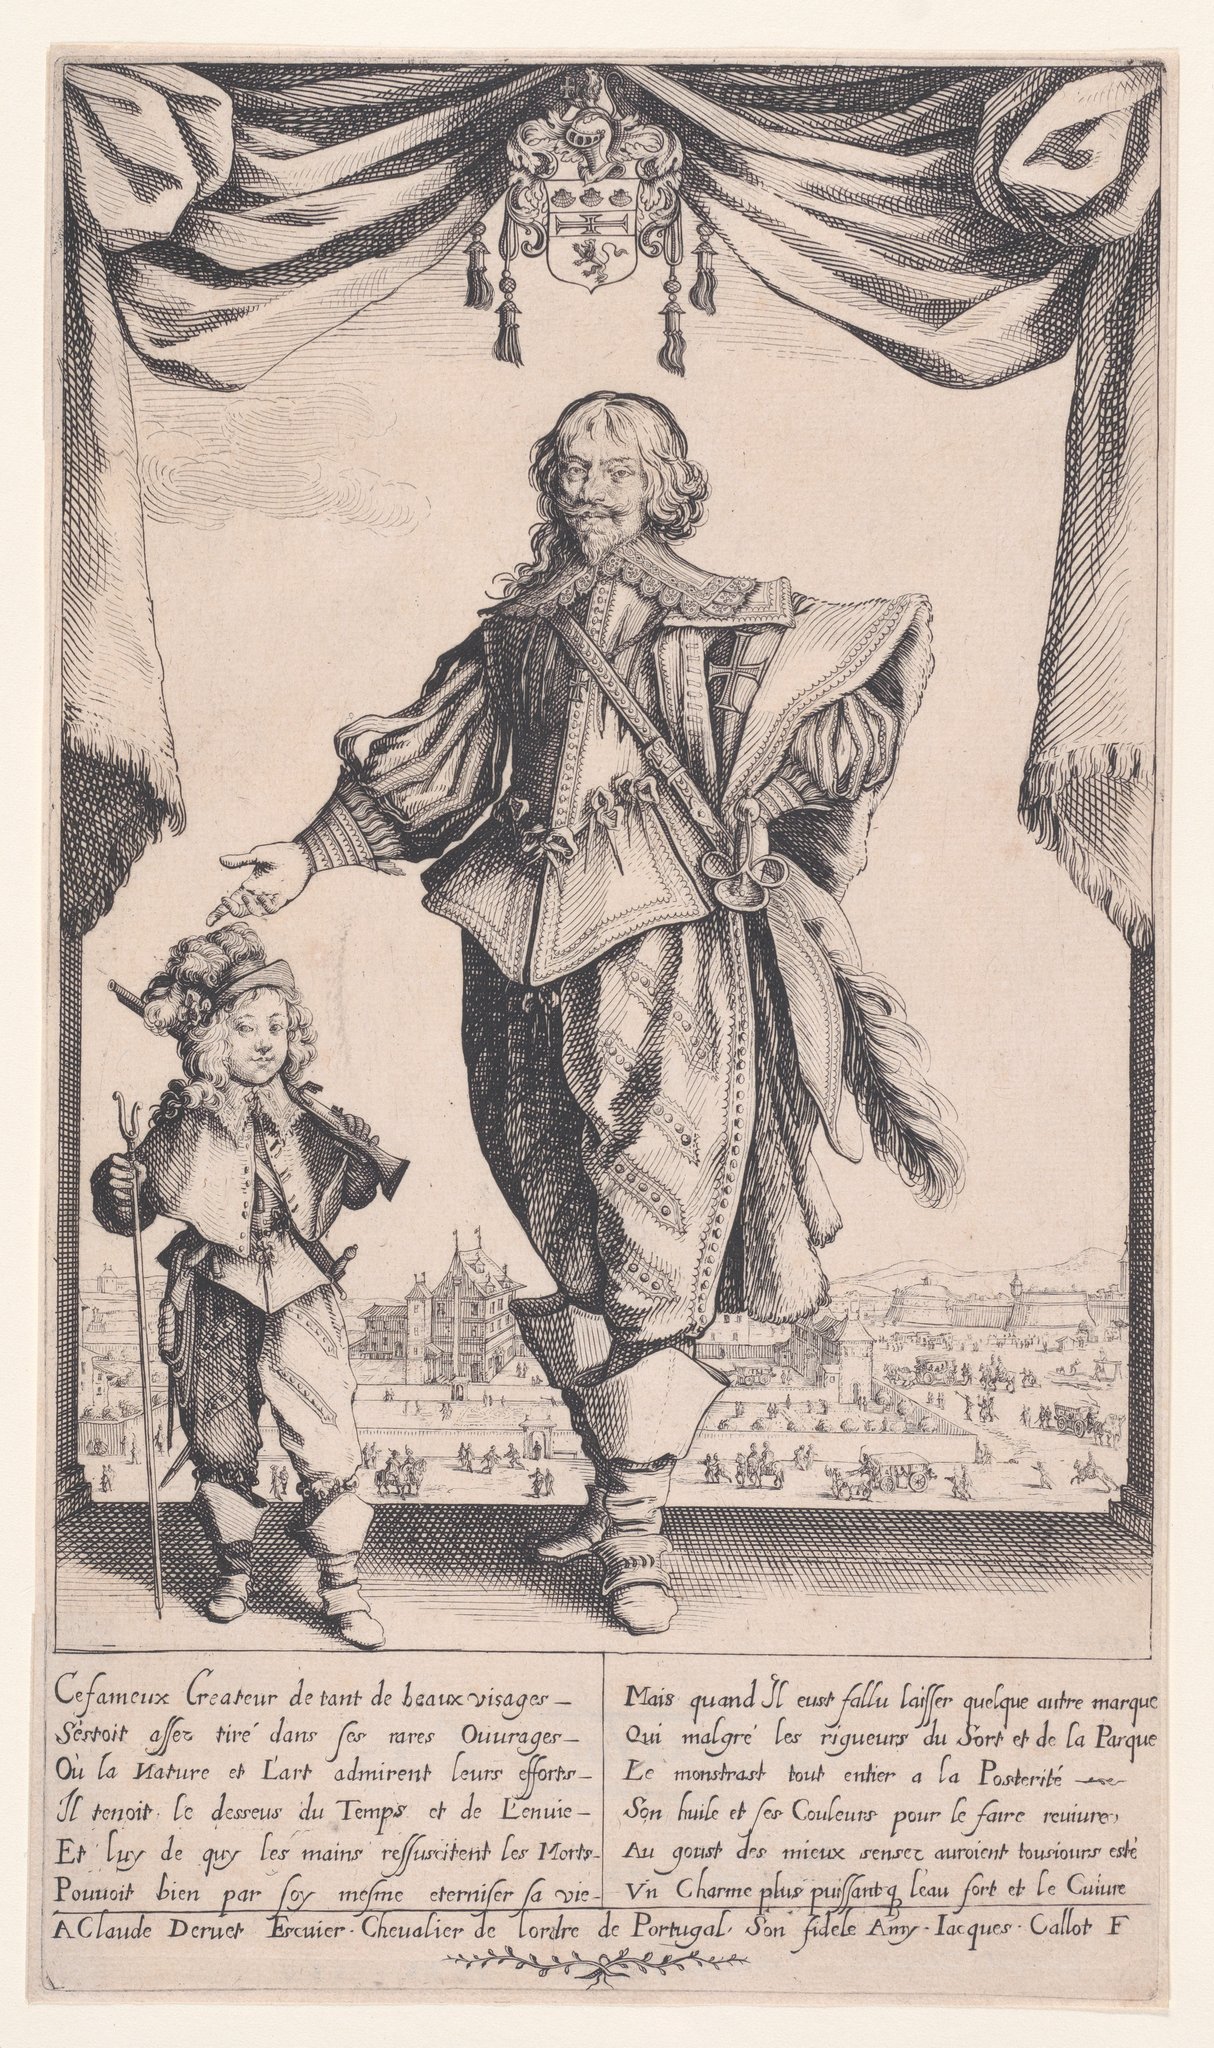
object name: print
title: Portrait of Claude Deruet and His Son, Jean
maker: jacques callot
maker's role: artist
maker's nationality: french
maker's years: 1592-1635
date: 1632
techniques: engraving, etching